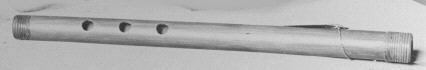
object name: fue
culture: japanese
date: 1801-1900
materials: bamboo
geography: japan